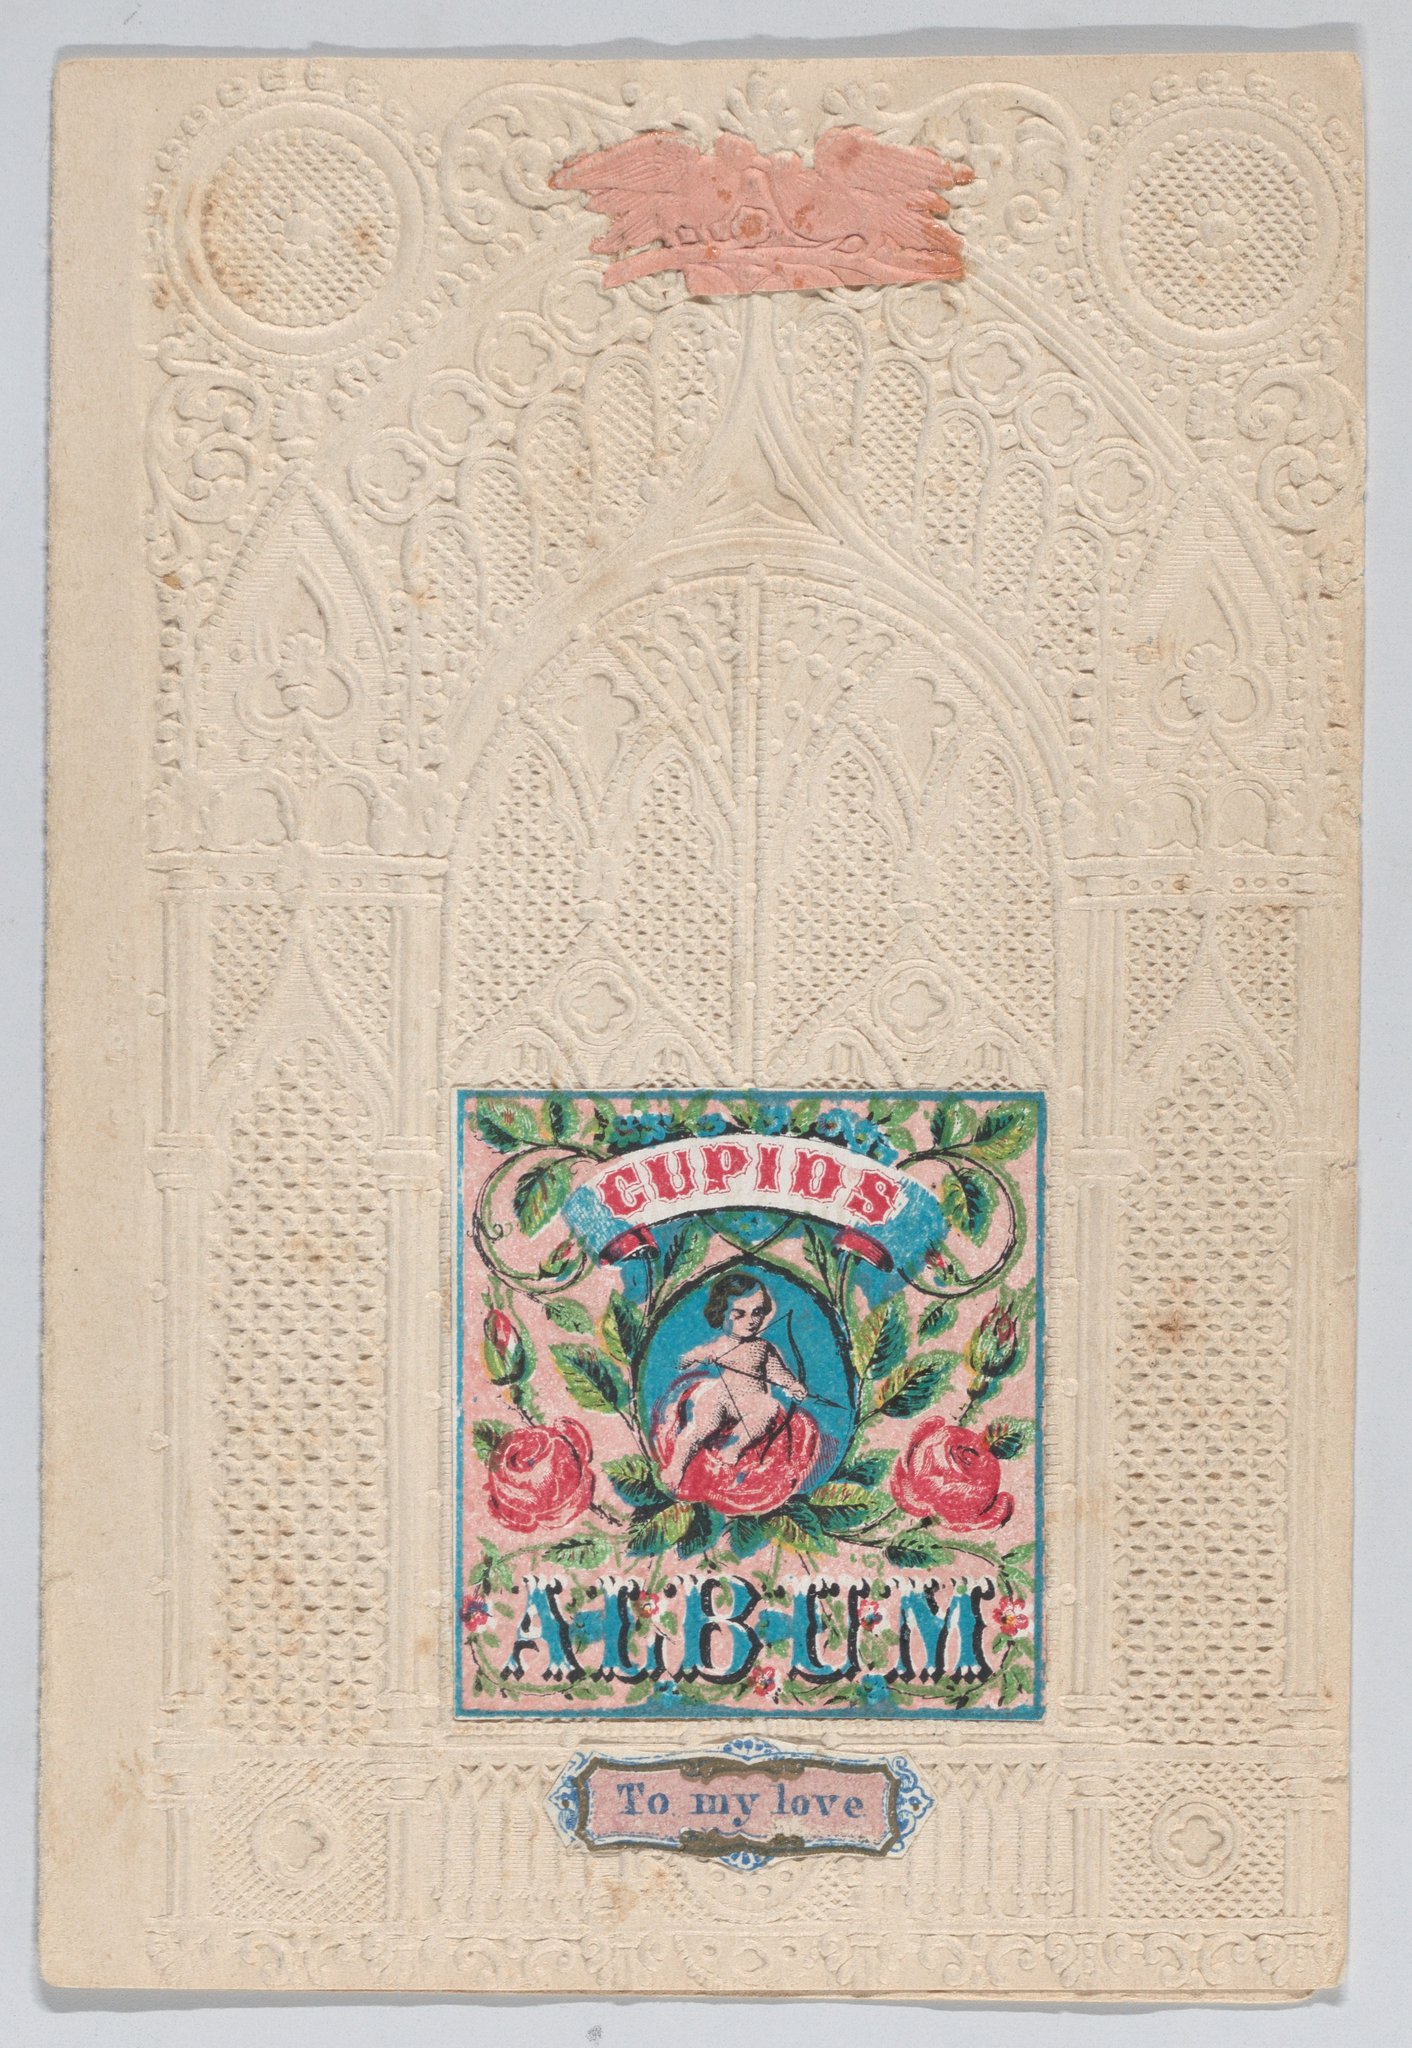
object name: valentine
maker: Anonymous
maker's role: artist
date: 1860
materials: lace, paper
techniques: chromolithography, embossing